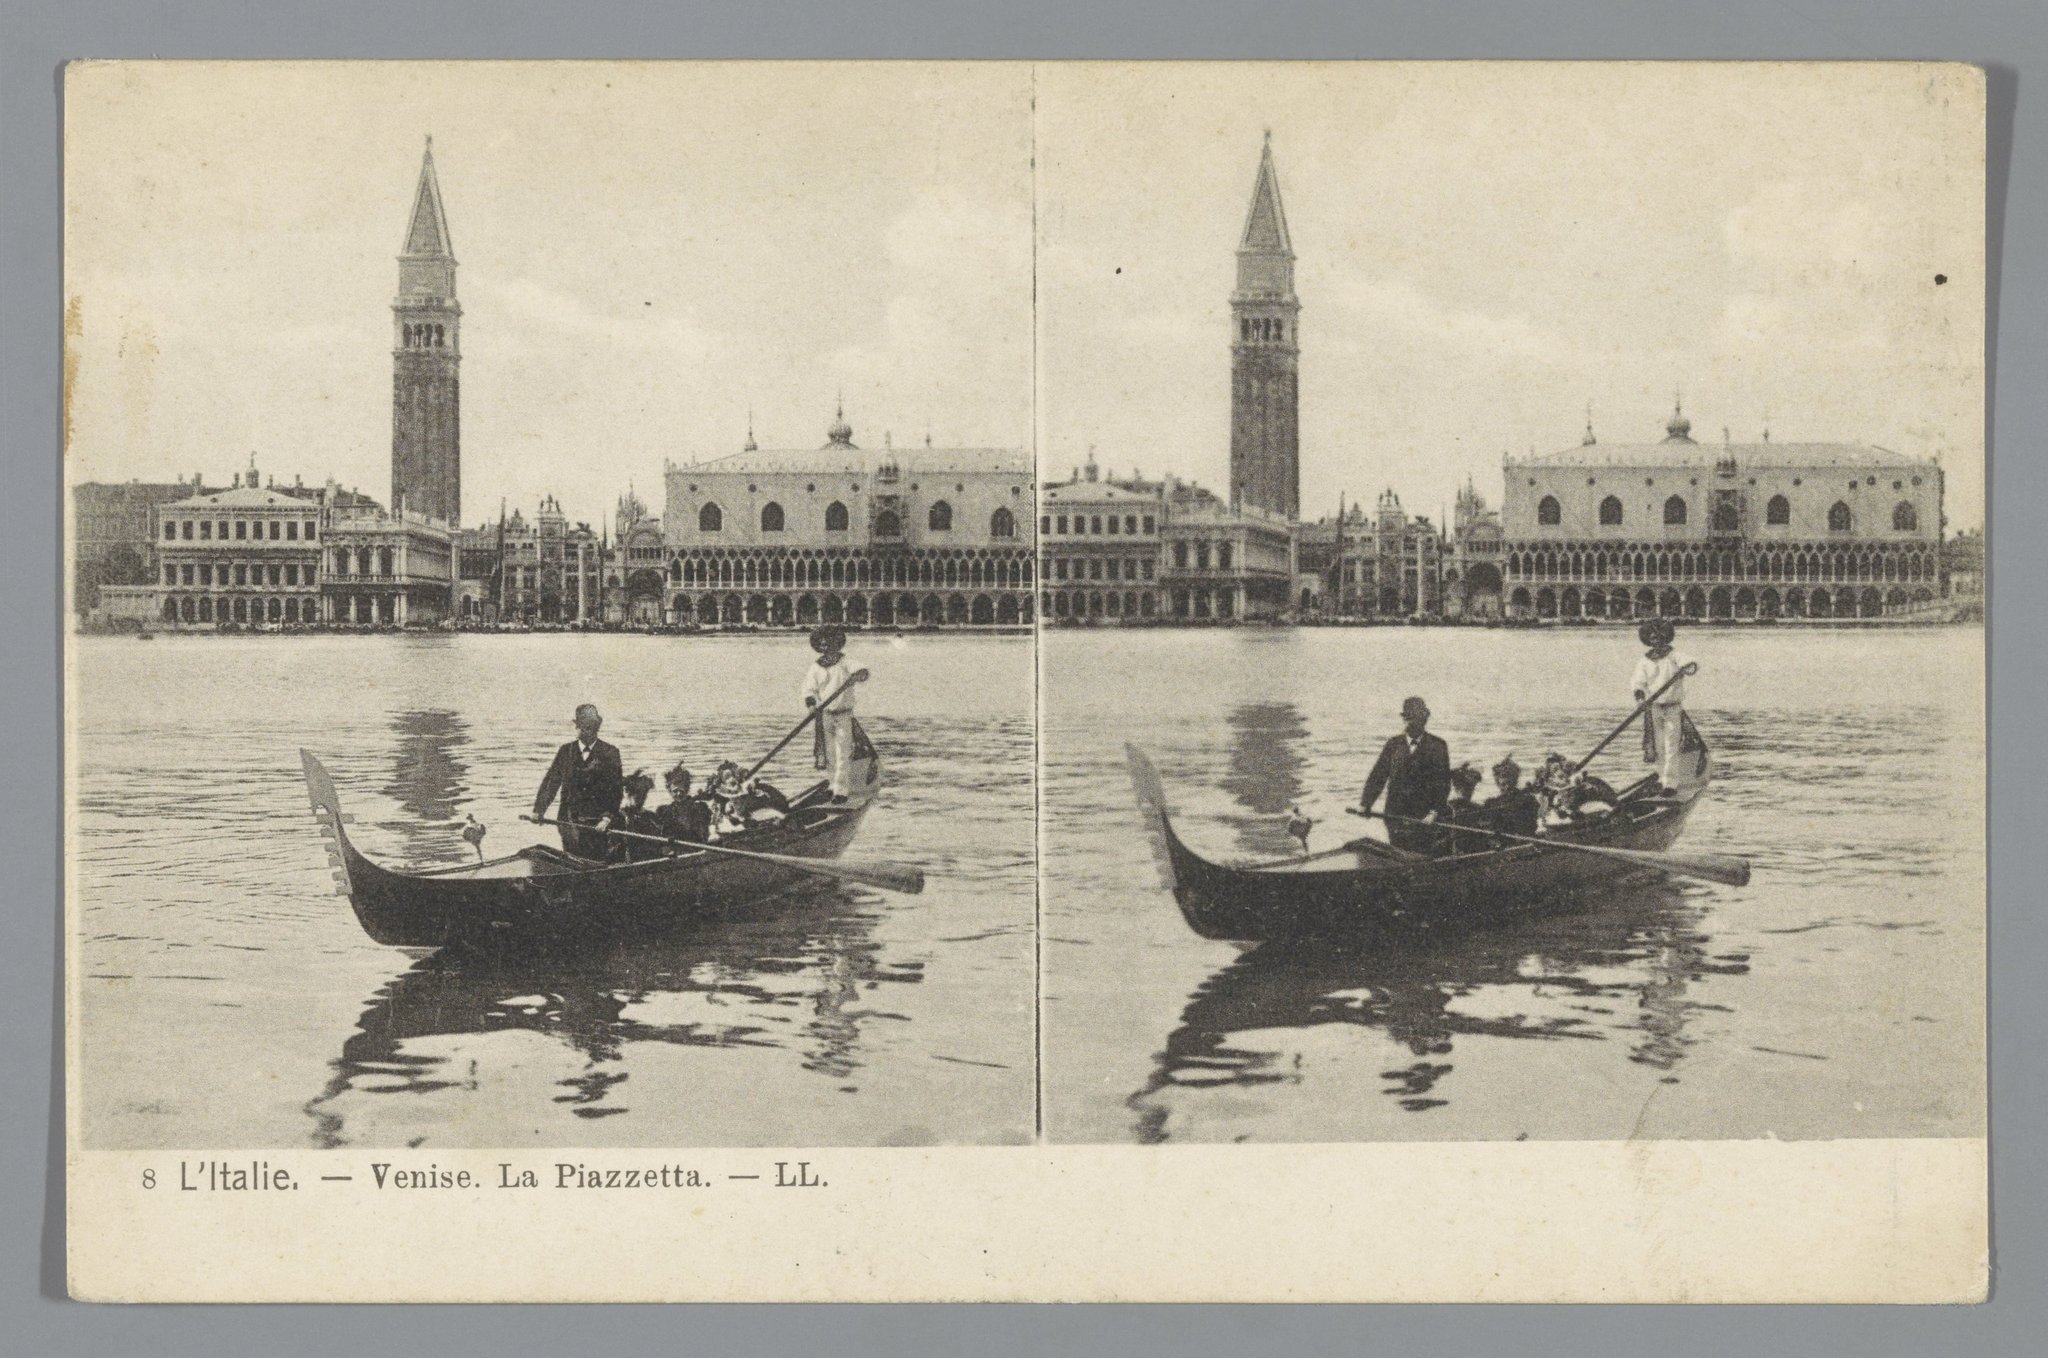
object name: photomechanical print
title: L'Italie. - Venise. La Piazzetta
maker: Anonymous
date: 1898-1920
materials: paper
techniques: photograph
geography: venice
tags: parts of church exterior and annexes: campanile, palace, gondola, venice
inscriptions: number: ‘8’